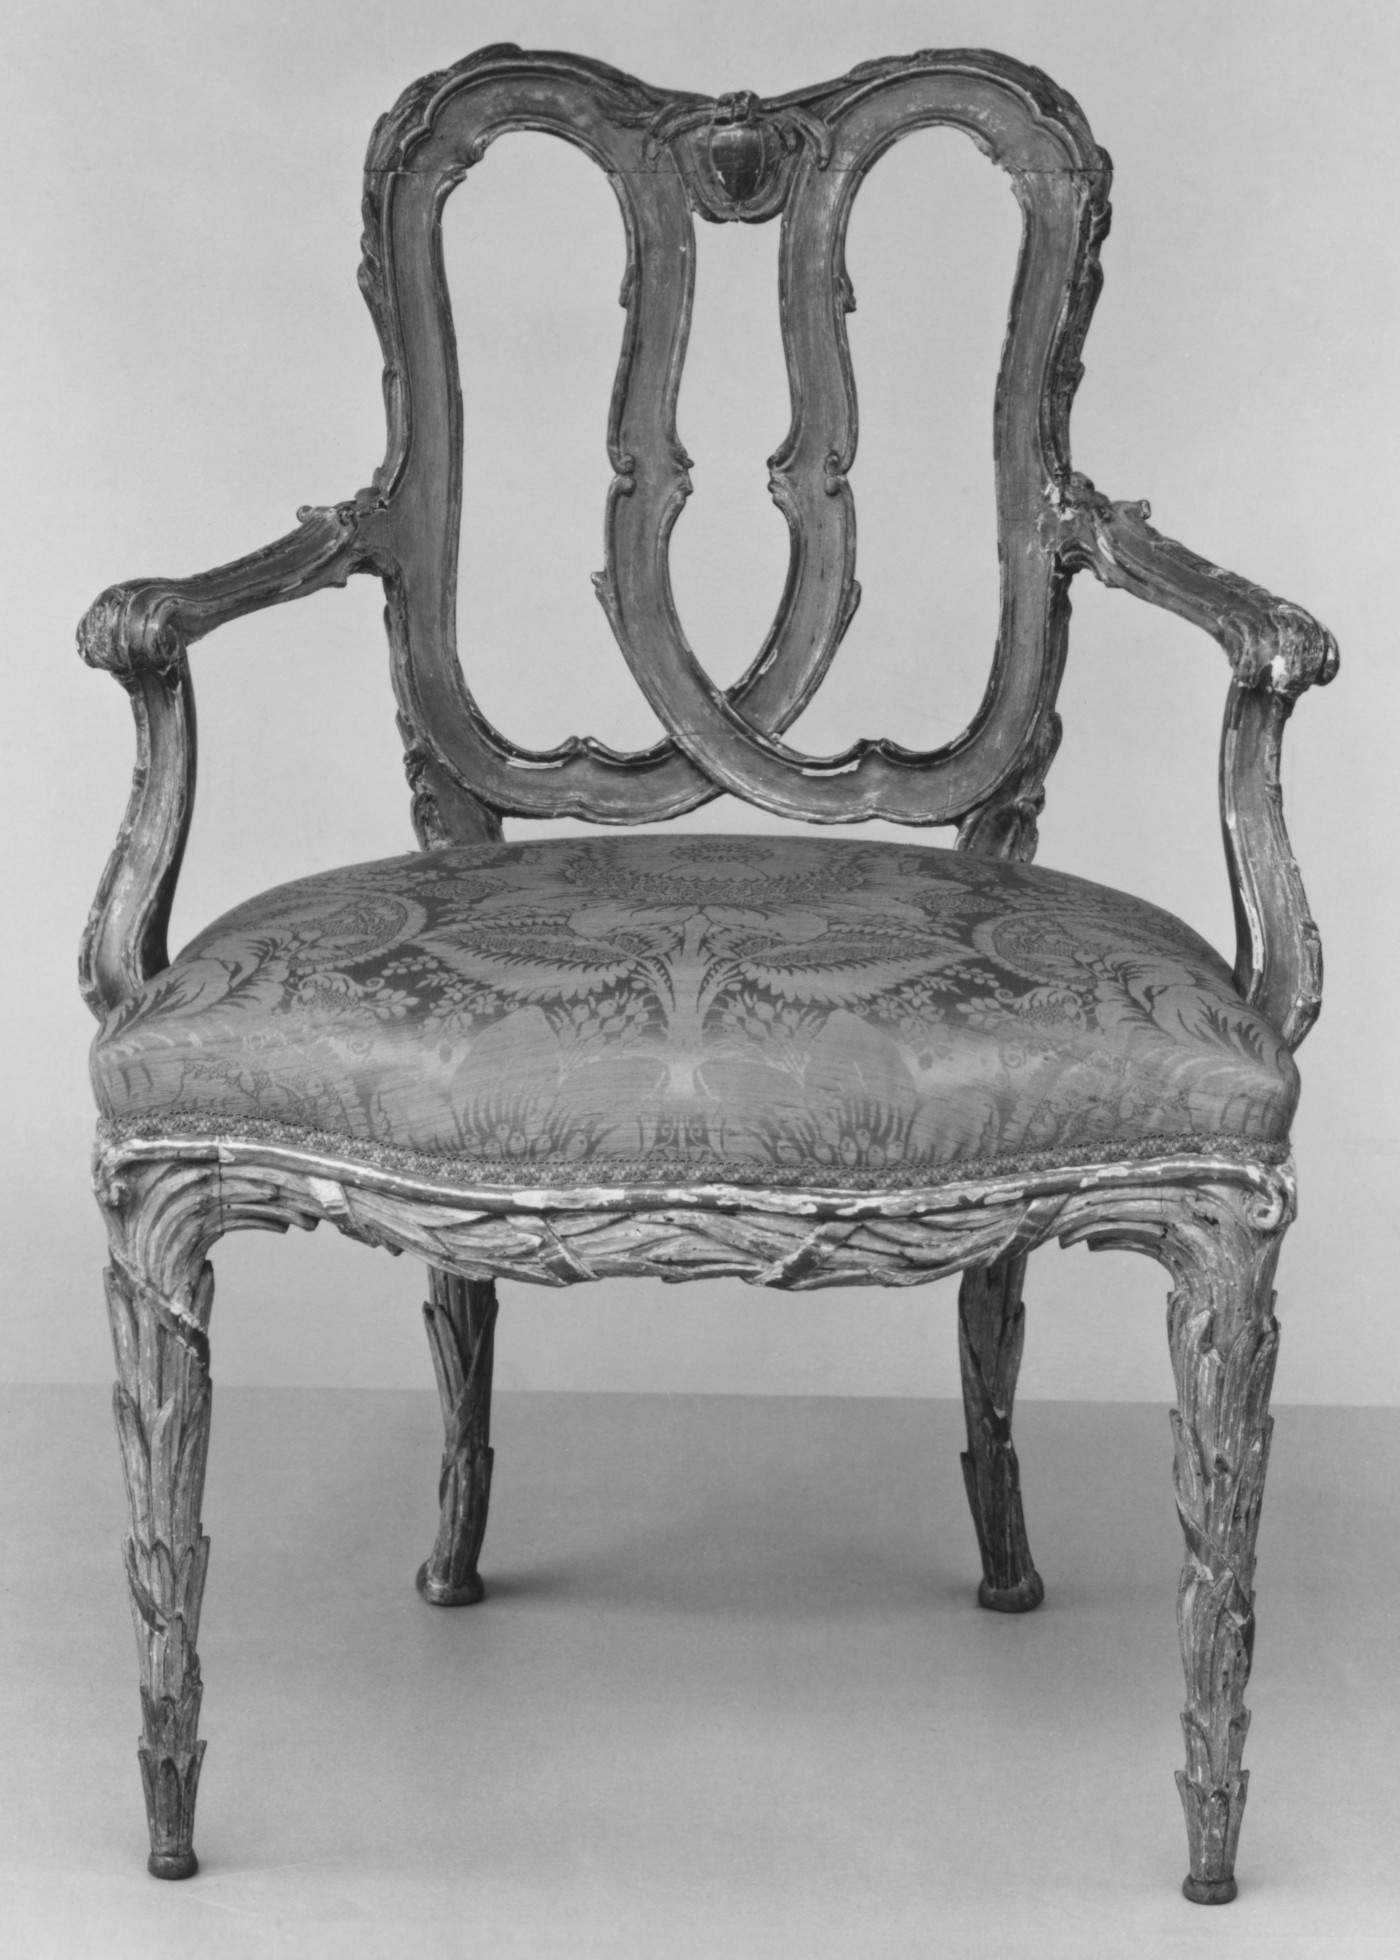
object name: armchair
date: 1751-1775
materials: wood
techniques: damask, gilding, painting